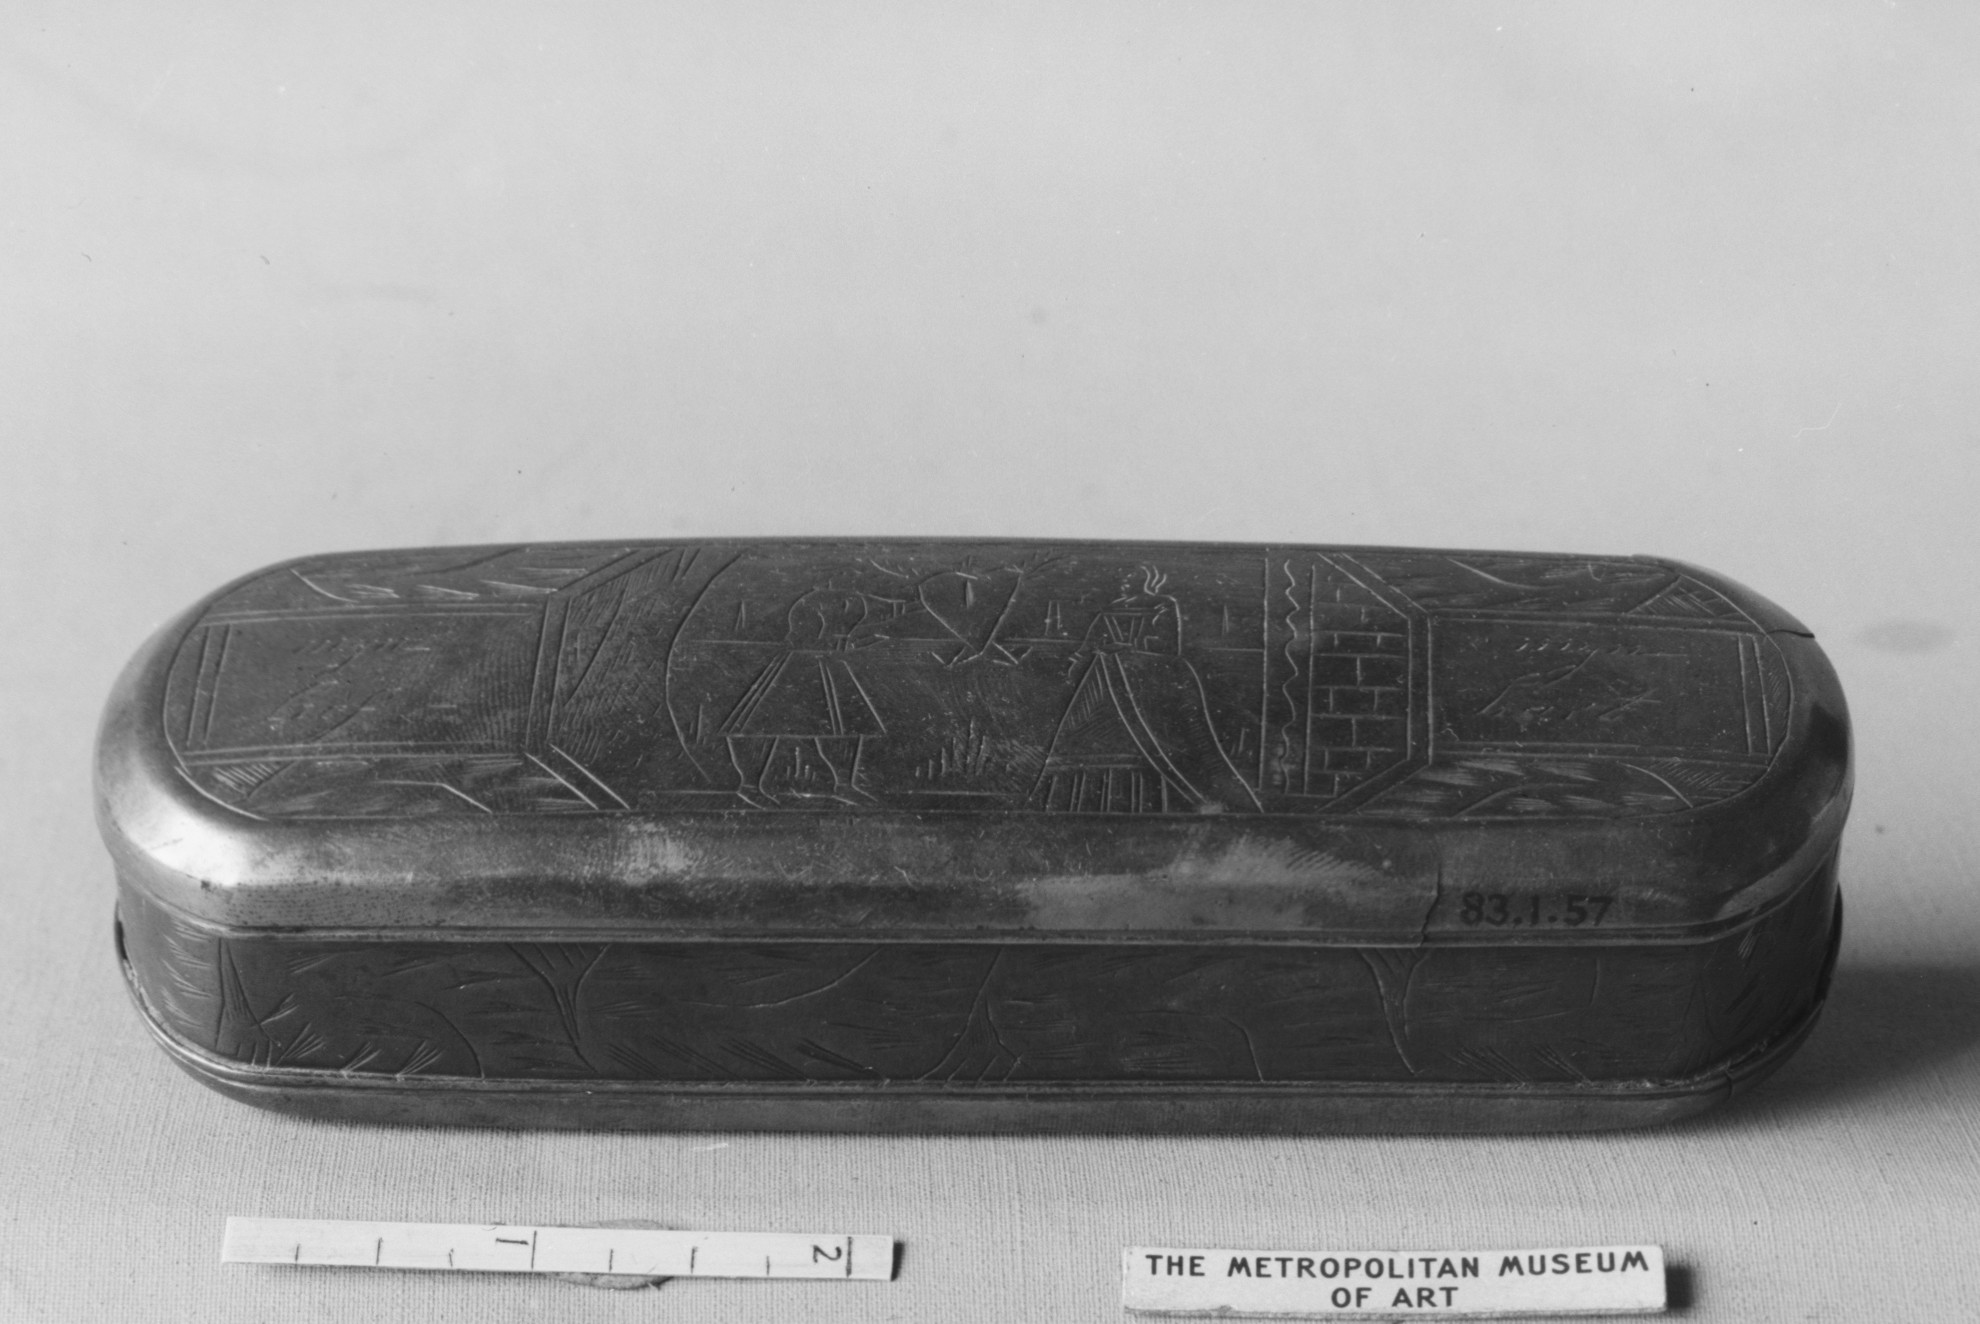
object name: tobacco box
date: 1567-1600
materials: brass, copper